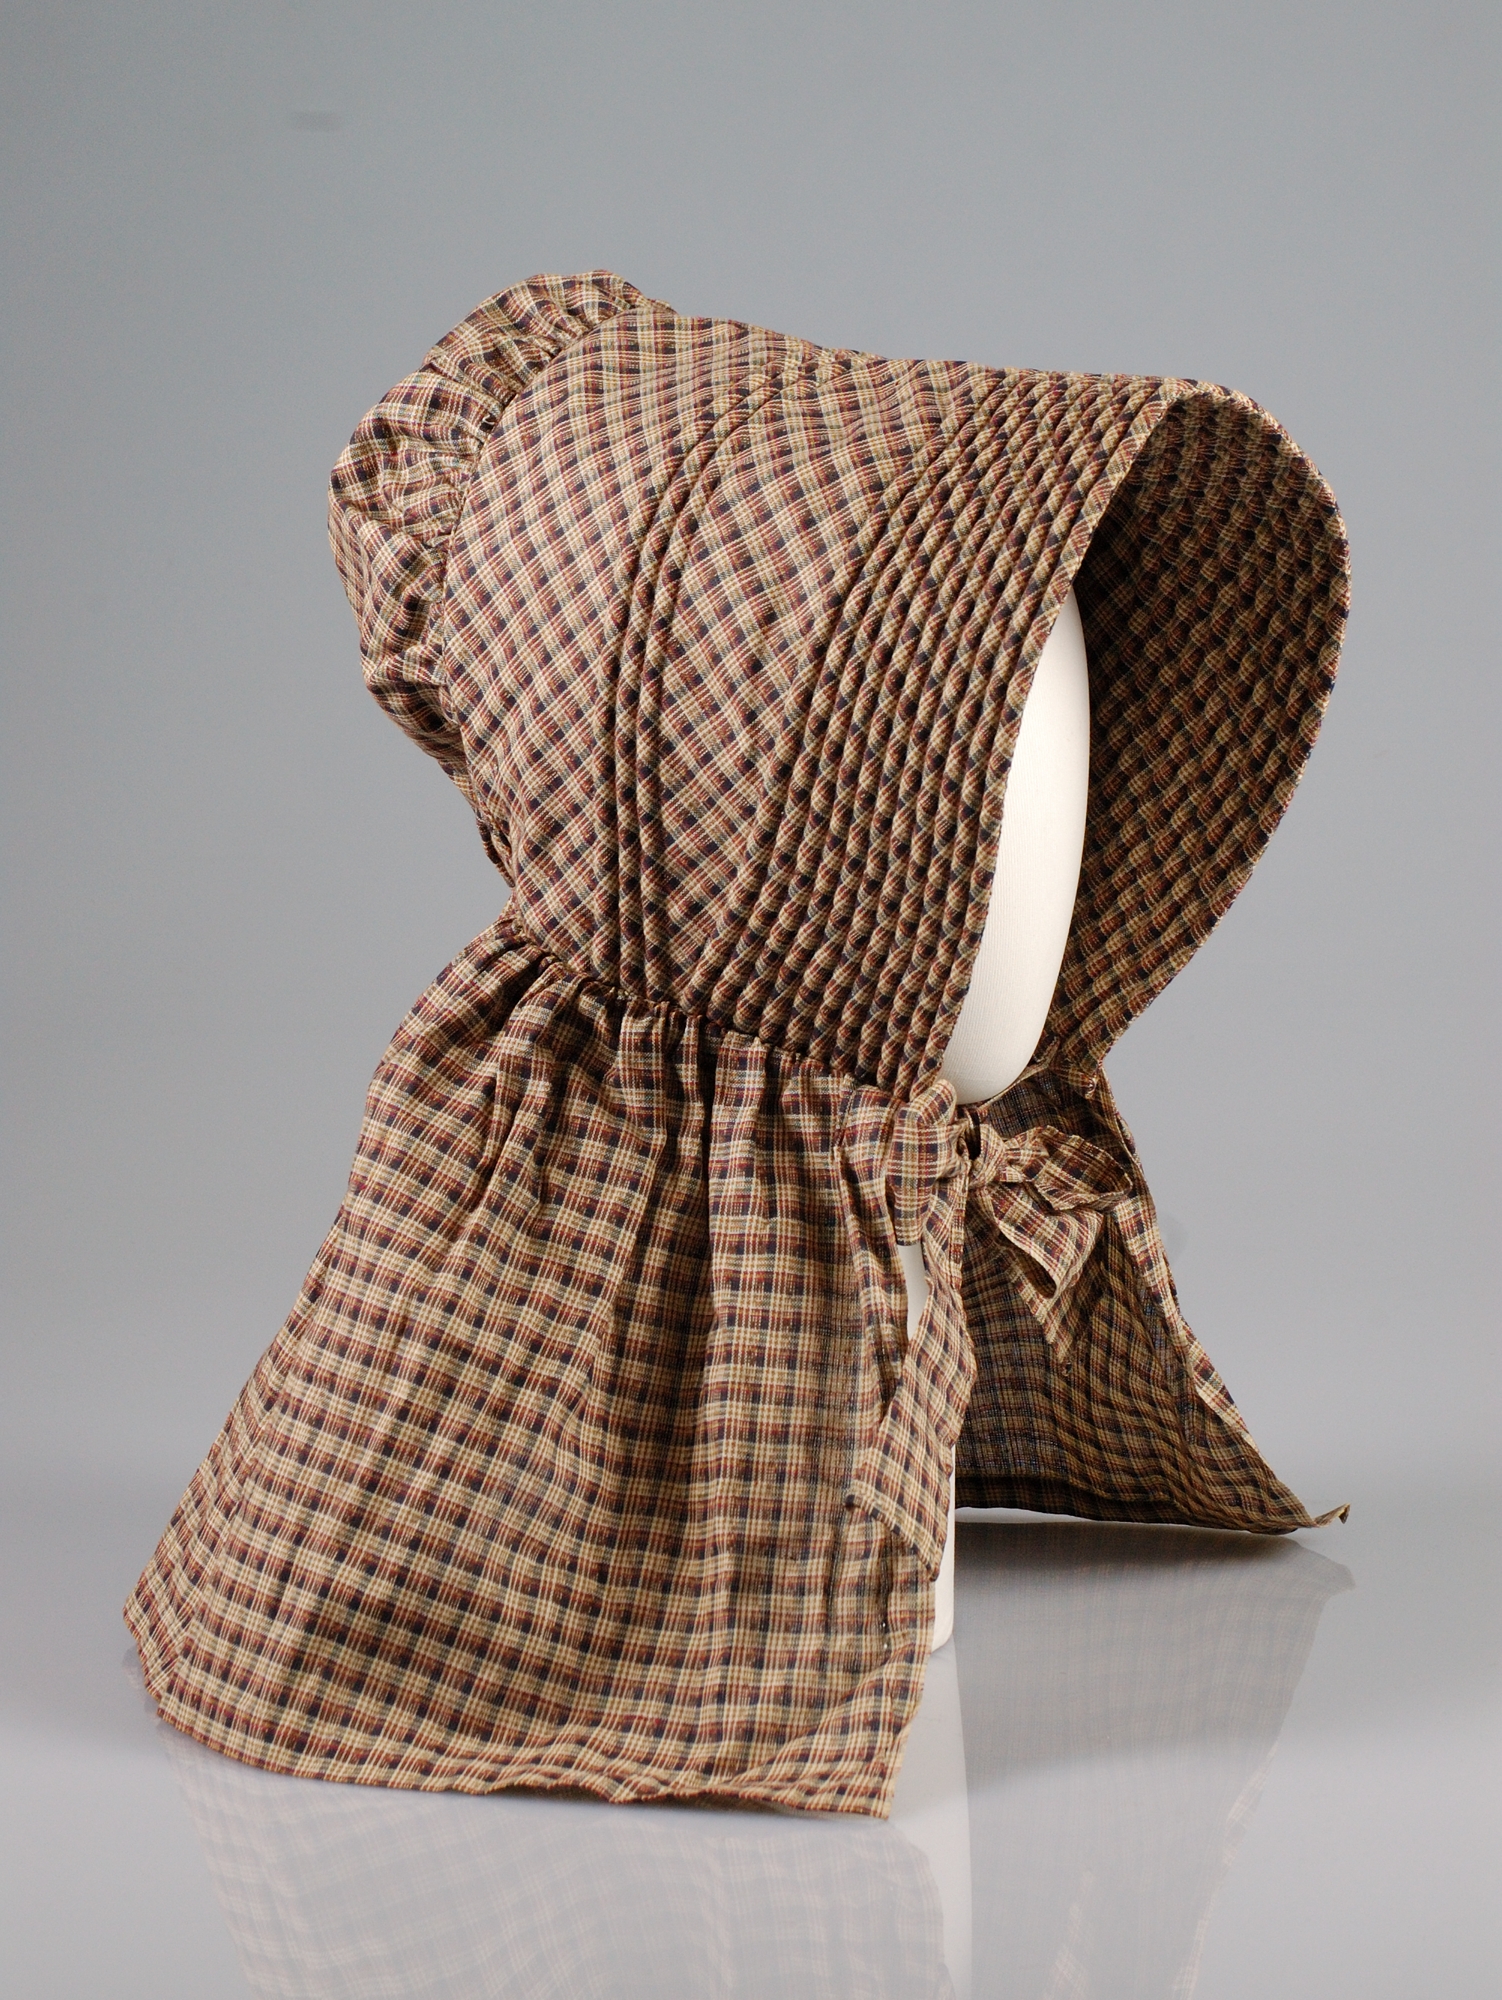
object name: sunbonnet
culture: american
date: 1840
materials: cotton